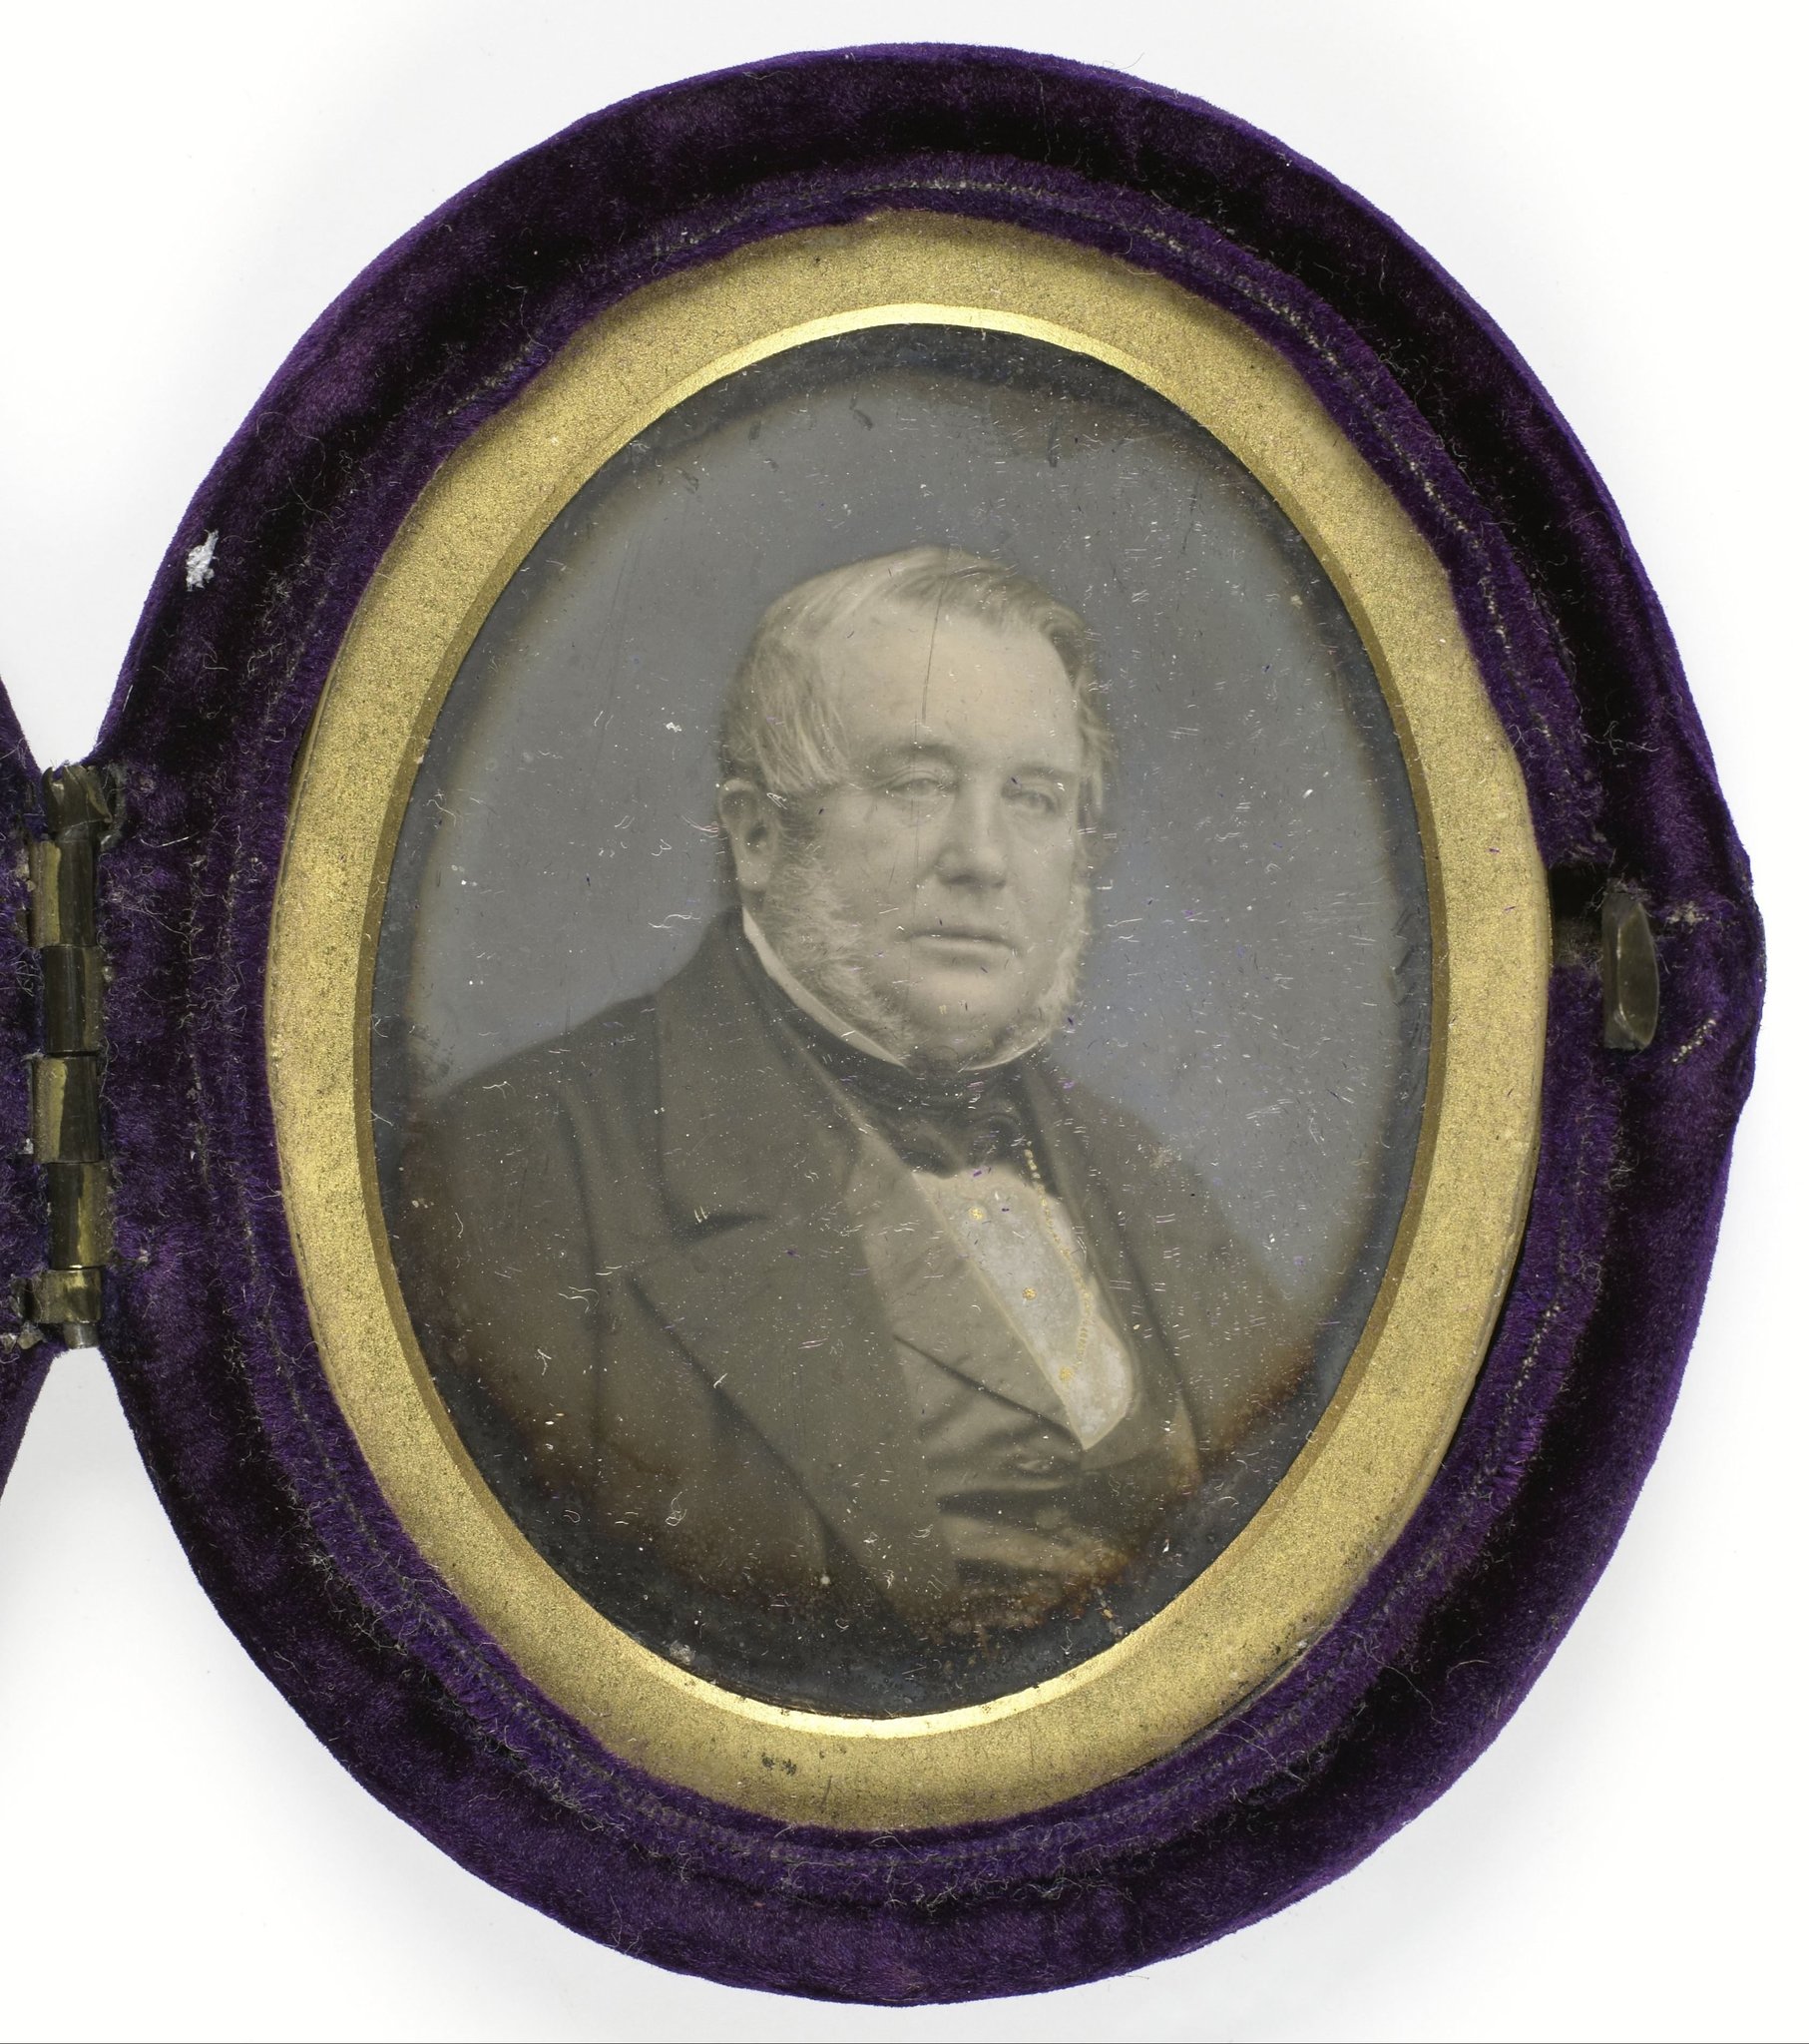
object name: photograph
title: Portret van een onbekende man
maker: Anonymous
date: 1840-1860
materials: copper, cotton, glass, velvet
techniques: daguerreotype, hand coloring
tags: adult man, historical persons